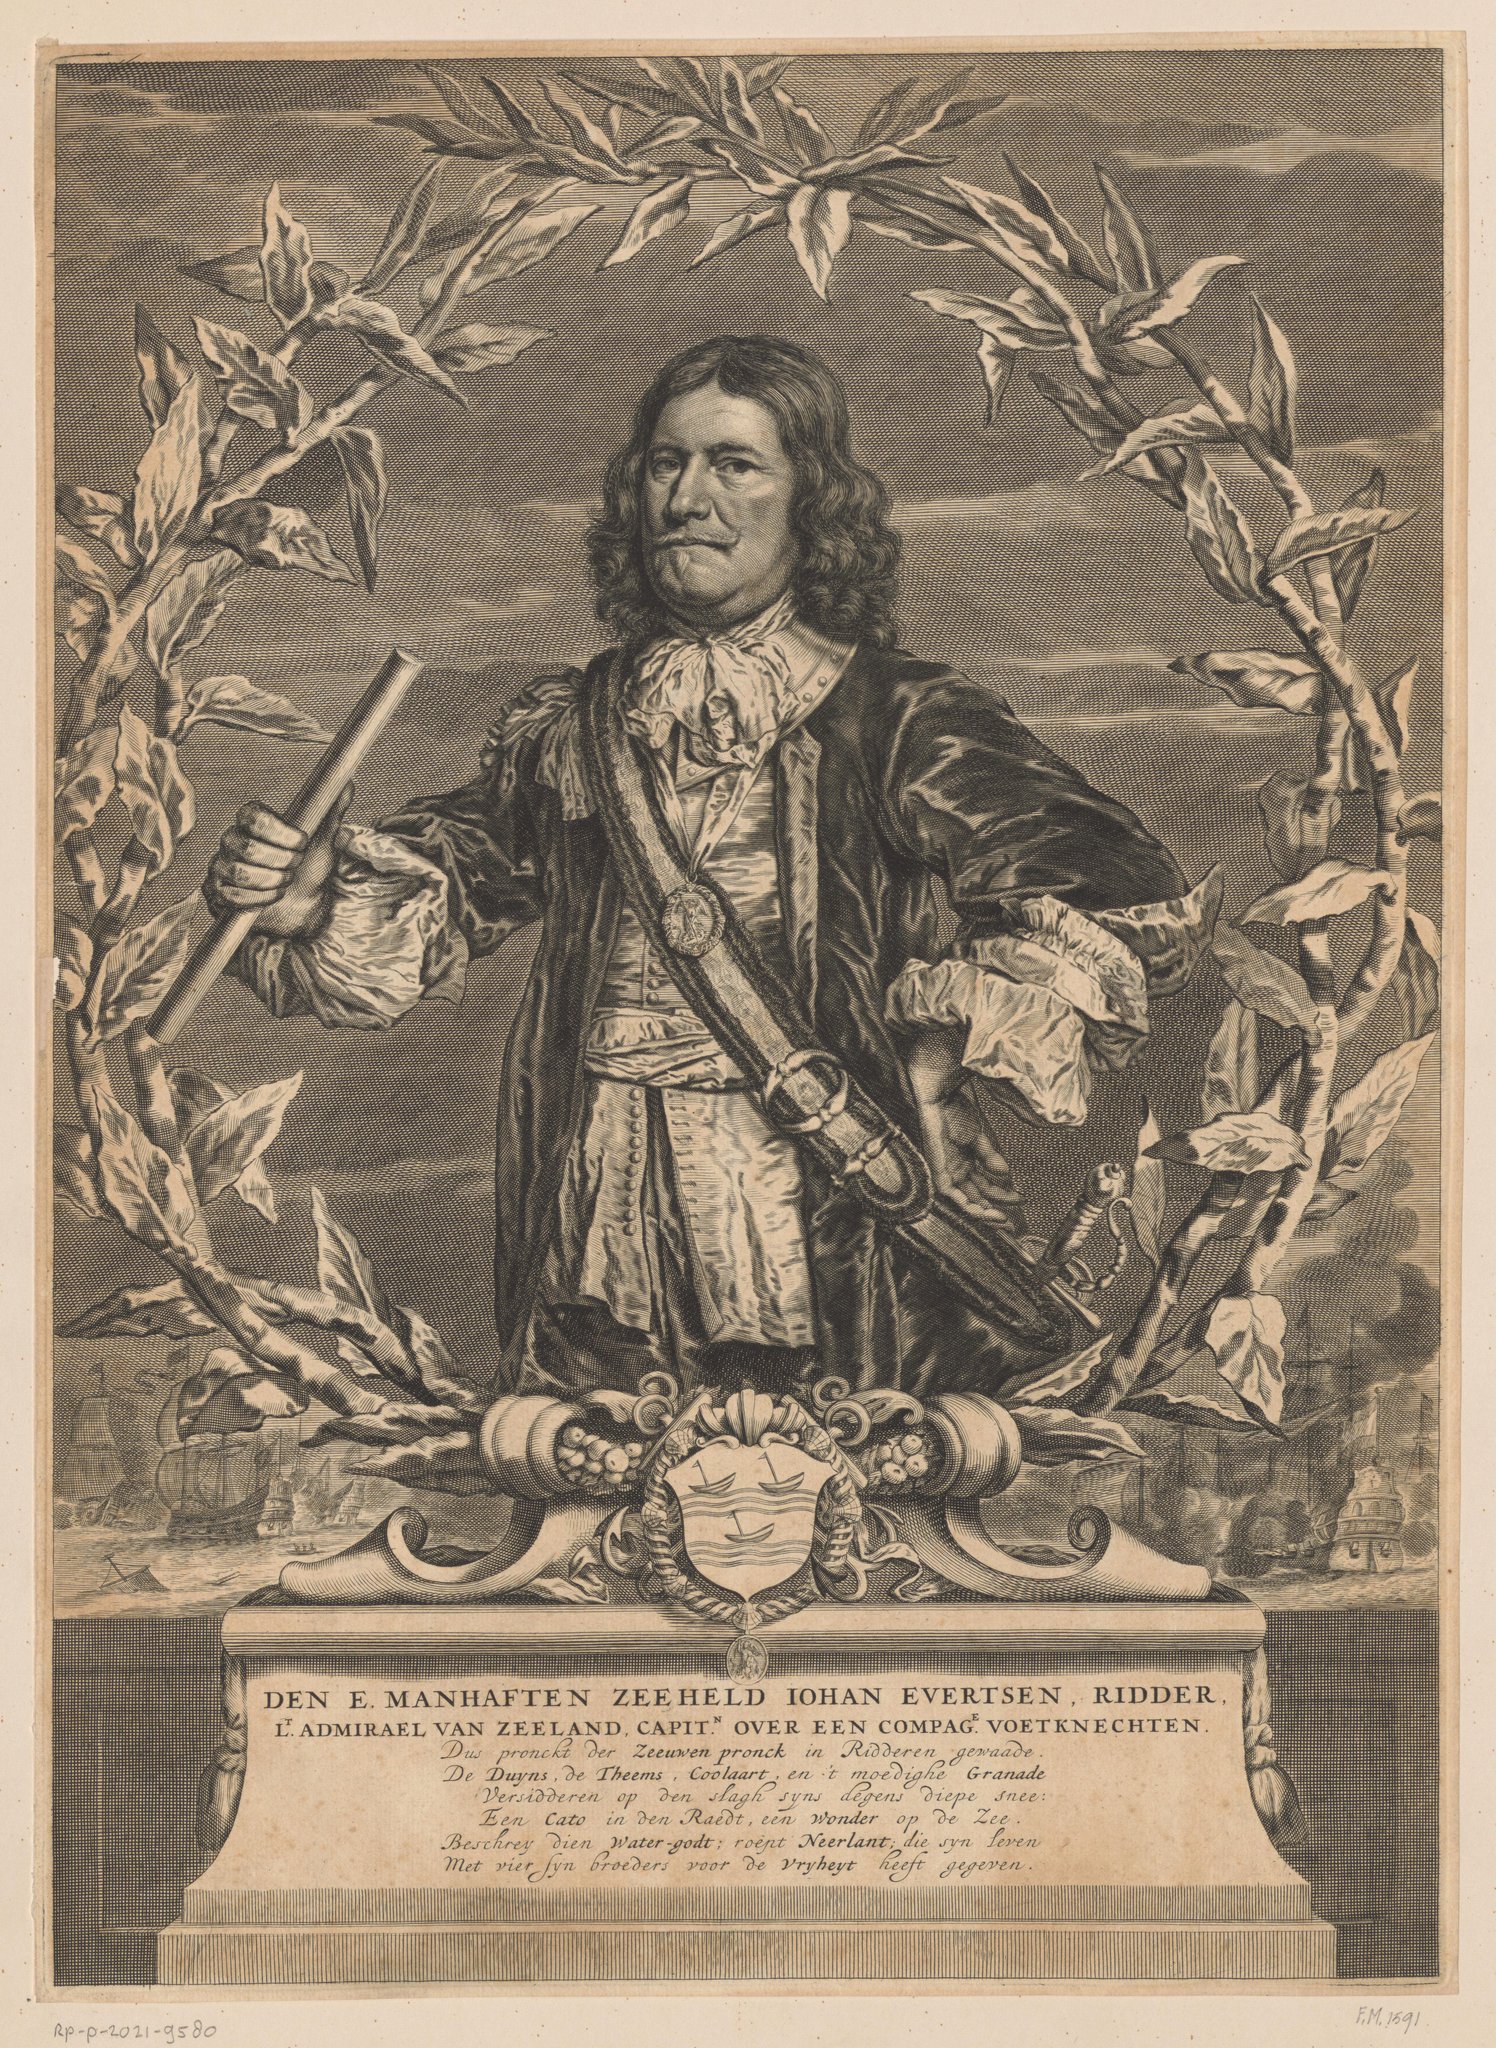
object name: print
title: Portret van Johan Evertsen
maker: arnold de jode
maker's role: print maker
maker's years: 1638-1669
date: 1666-1669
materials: paper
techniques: engraving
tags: flushing, battle (+ naval force), historical persons, commander-in-chief, admiral, battle of st. james's day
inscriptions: number: ‘No. 35’, collector's mark: Lugt 2228, inscription: ‘Coll:Franken’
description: Op de achtergrond een zeegevecht, waarschijnlijk de Tweedaagse Zeeslag waarbij Johan Evertsen overleed. Met zesregelig lofdicht in het Nederlands.